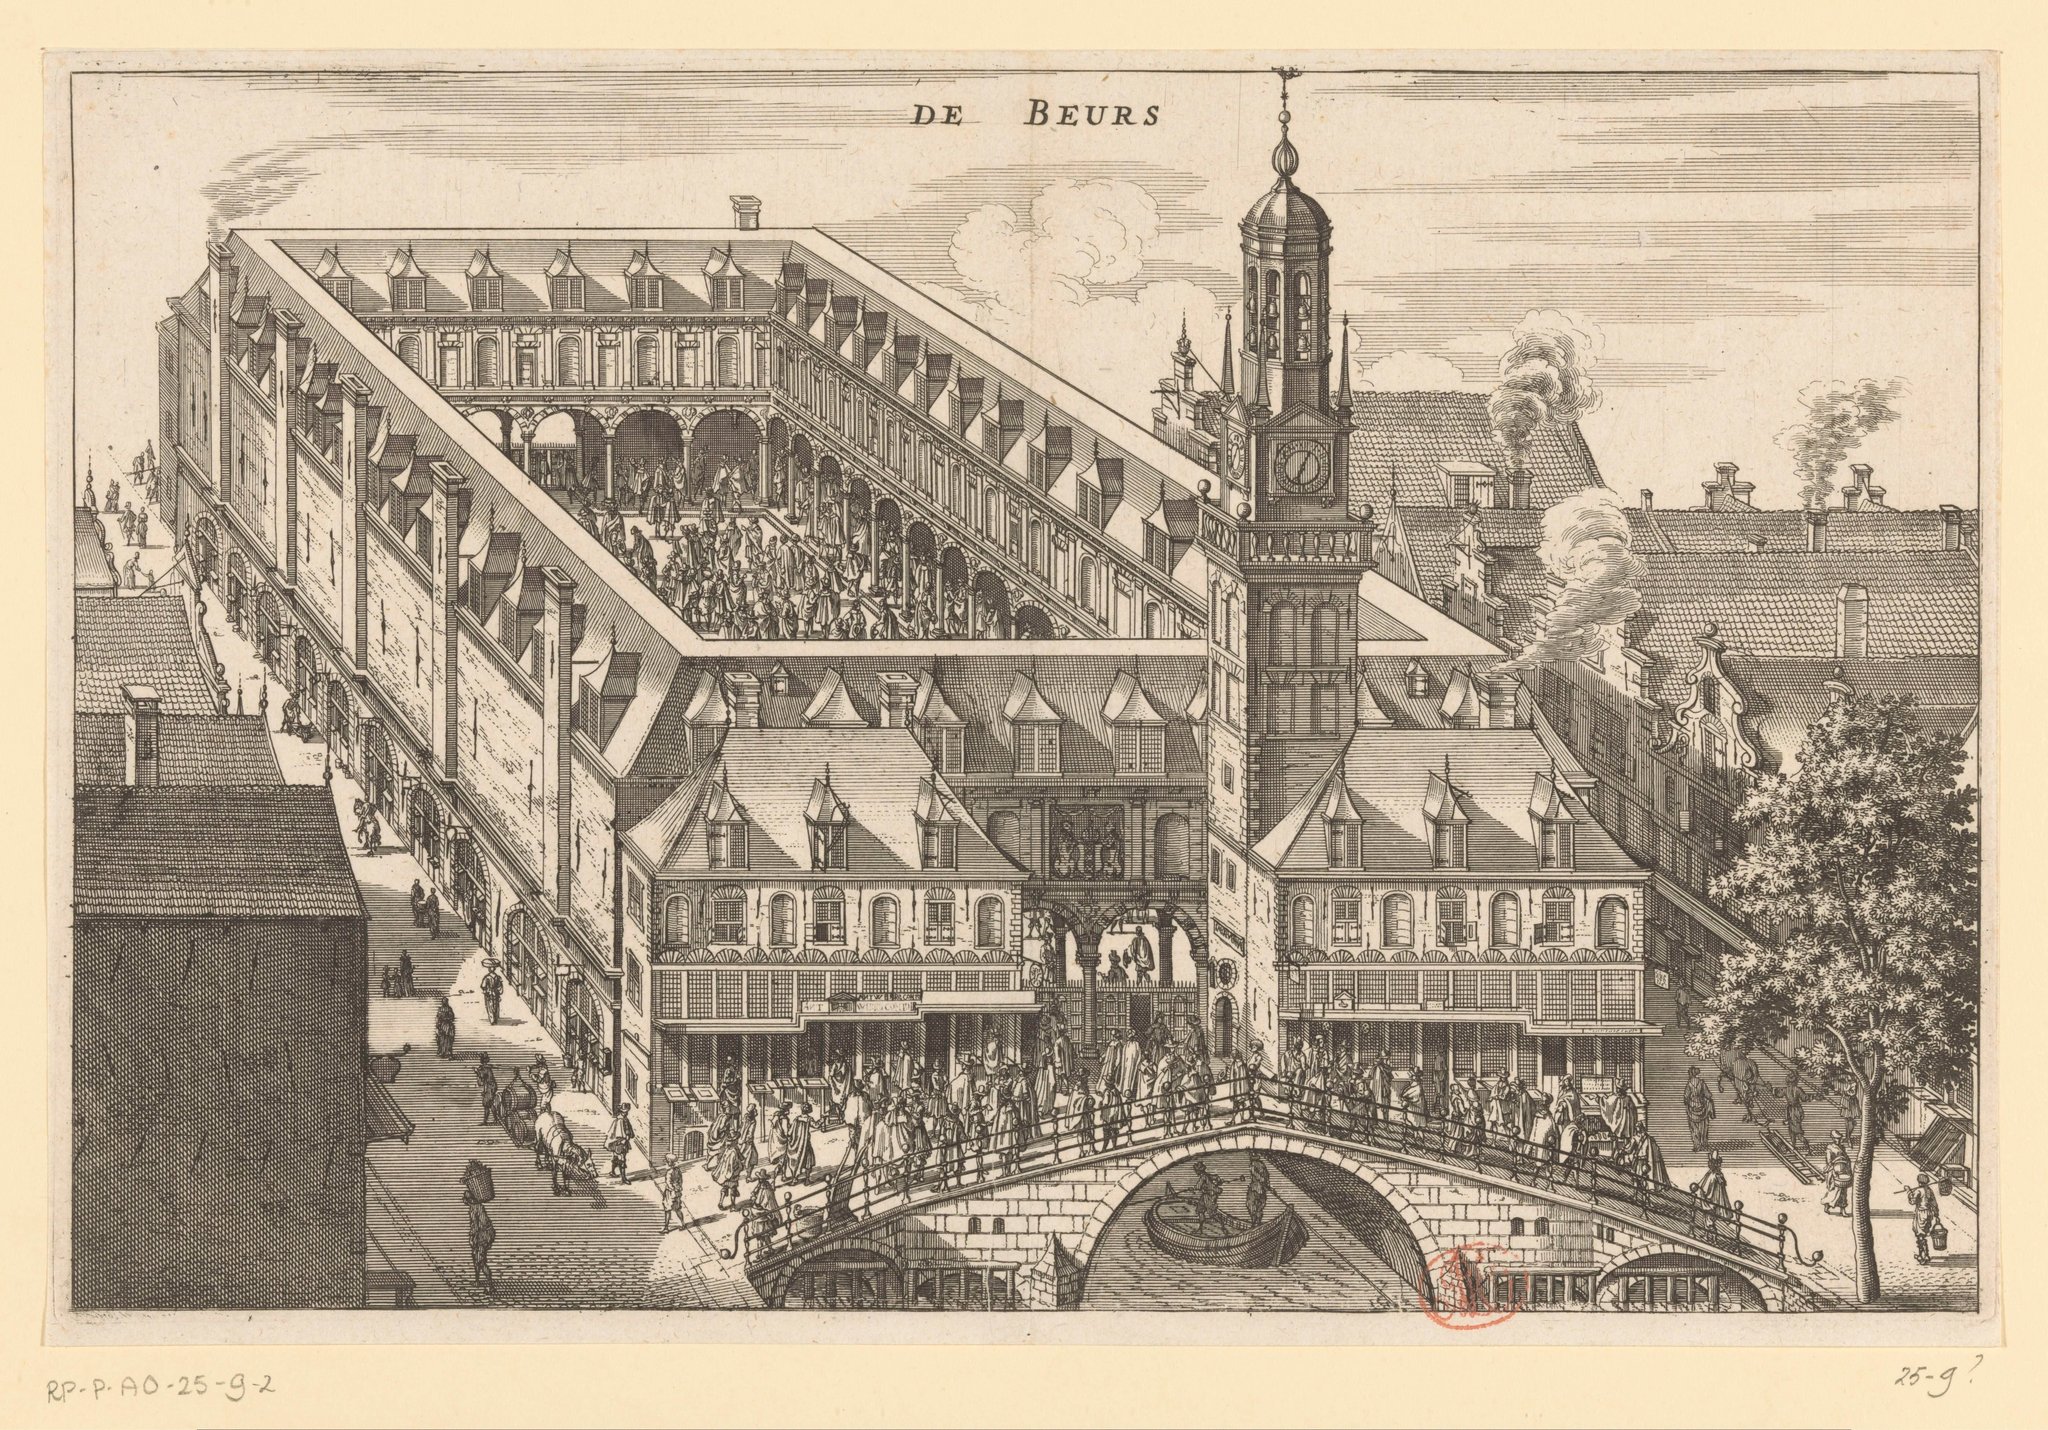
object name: book illustration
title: Vogelvluchtgezicht op de Beurs van Hendrik de Keyser te Amsterdam, voor 1668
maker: jacob van meurs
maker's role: draughtsman, print maker, publisher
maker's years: 1619-1680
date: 1663-1664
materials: paper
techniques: engraving, etching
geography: amsterdam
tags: bridge in city across river, canal, etc. (+ city(-scape) with figures, staffage), stock exchange, stock-market, courtyard, street (+ city(-scape) with figures, staffage)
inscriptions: collector's mark: Lugt 195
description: Huidige staat van prent ook gebruikt in: Dapper, Olfert. Historische beschryving der stadt Amsterdam: waer in de voornaemste geschiedenissen (na een kort verhael van gansch Hollant en d'omleggende dorpen (…). Amsterdam: Jacob van Meurs, 1663.* En in: Zesen, Philipp von. Beschreibung der Stadt Amsterdam: darinnen von derselben ersten Ursprunge bis auf gegenwärtigen Zustand (…). Amsterdam: Joachim Nosche, 1664. * In sommige exemplaren van deze uitgave komt de huidige staat van de prent voor. In andere exemplaren is een latere staat ingebonden, waarop boven de Nederlandse een Franse titel is toegevoegd.